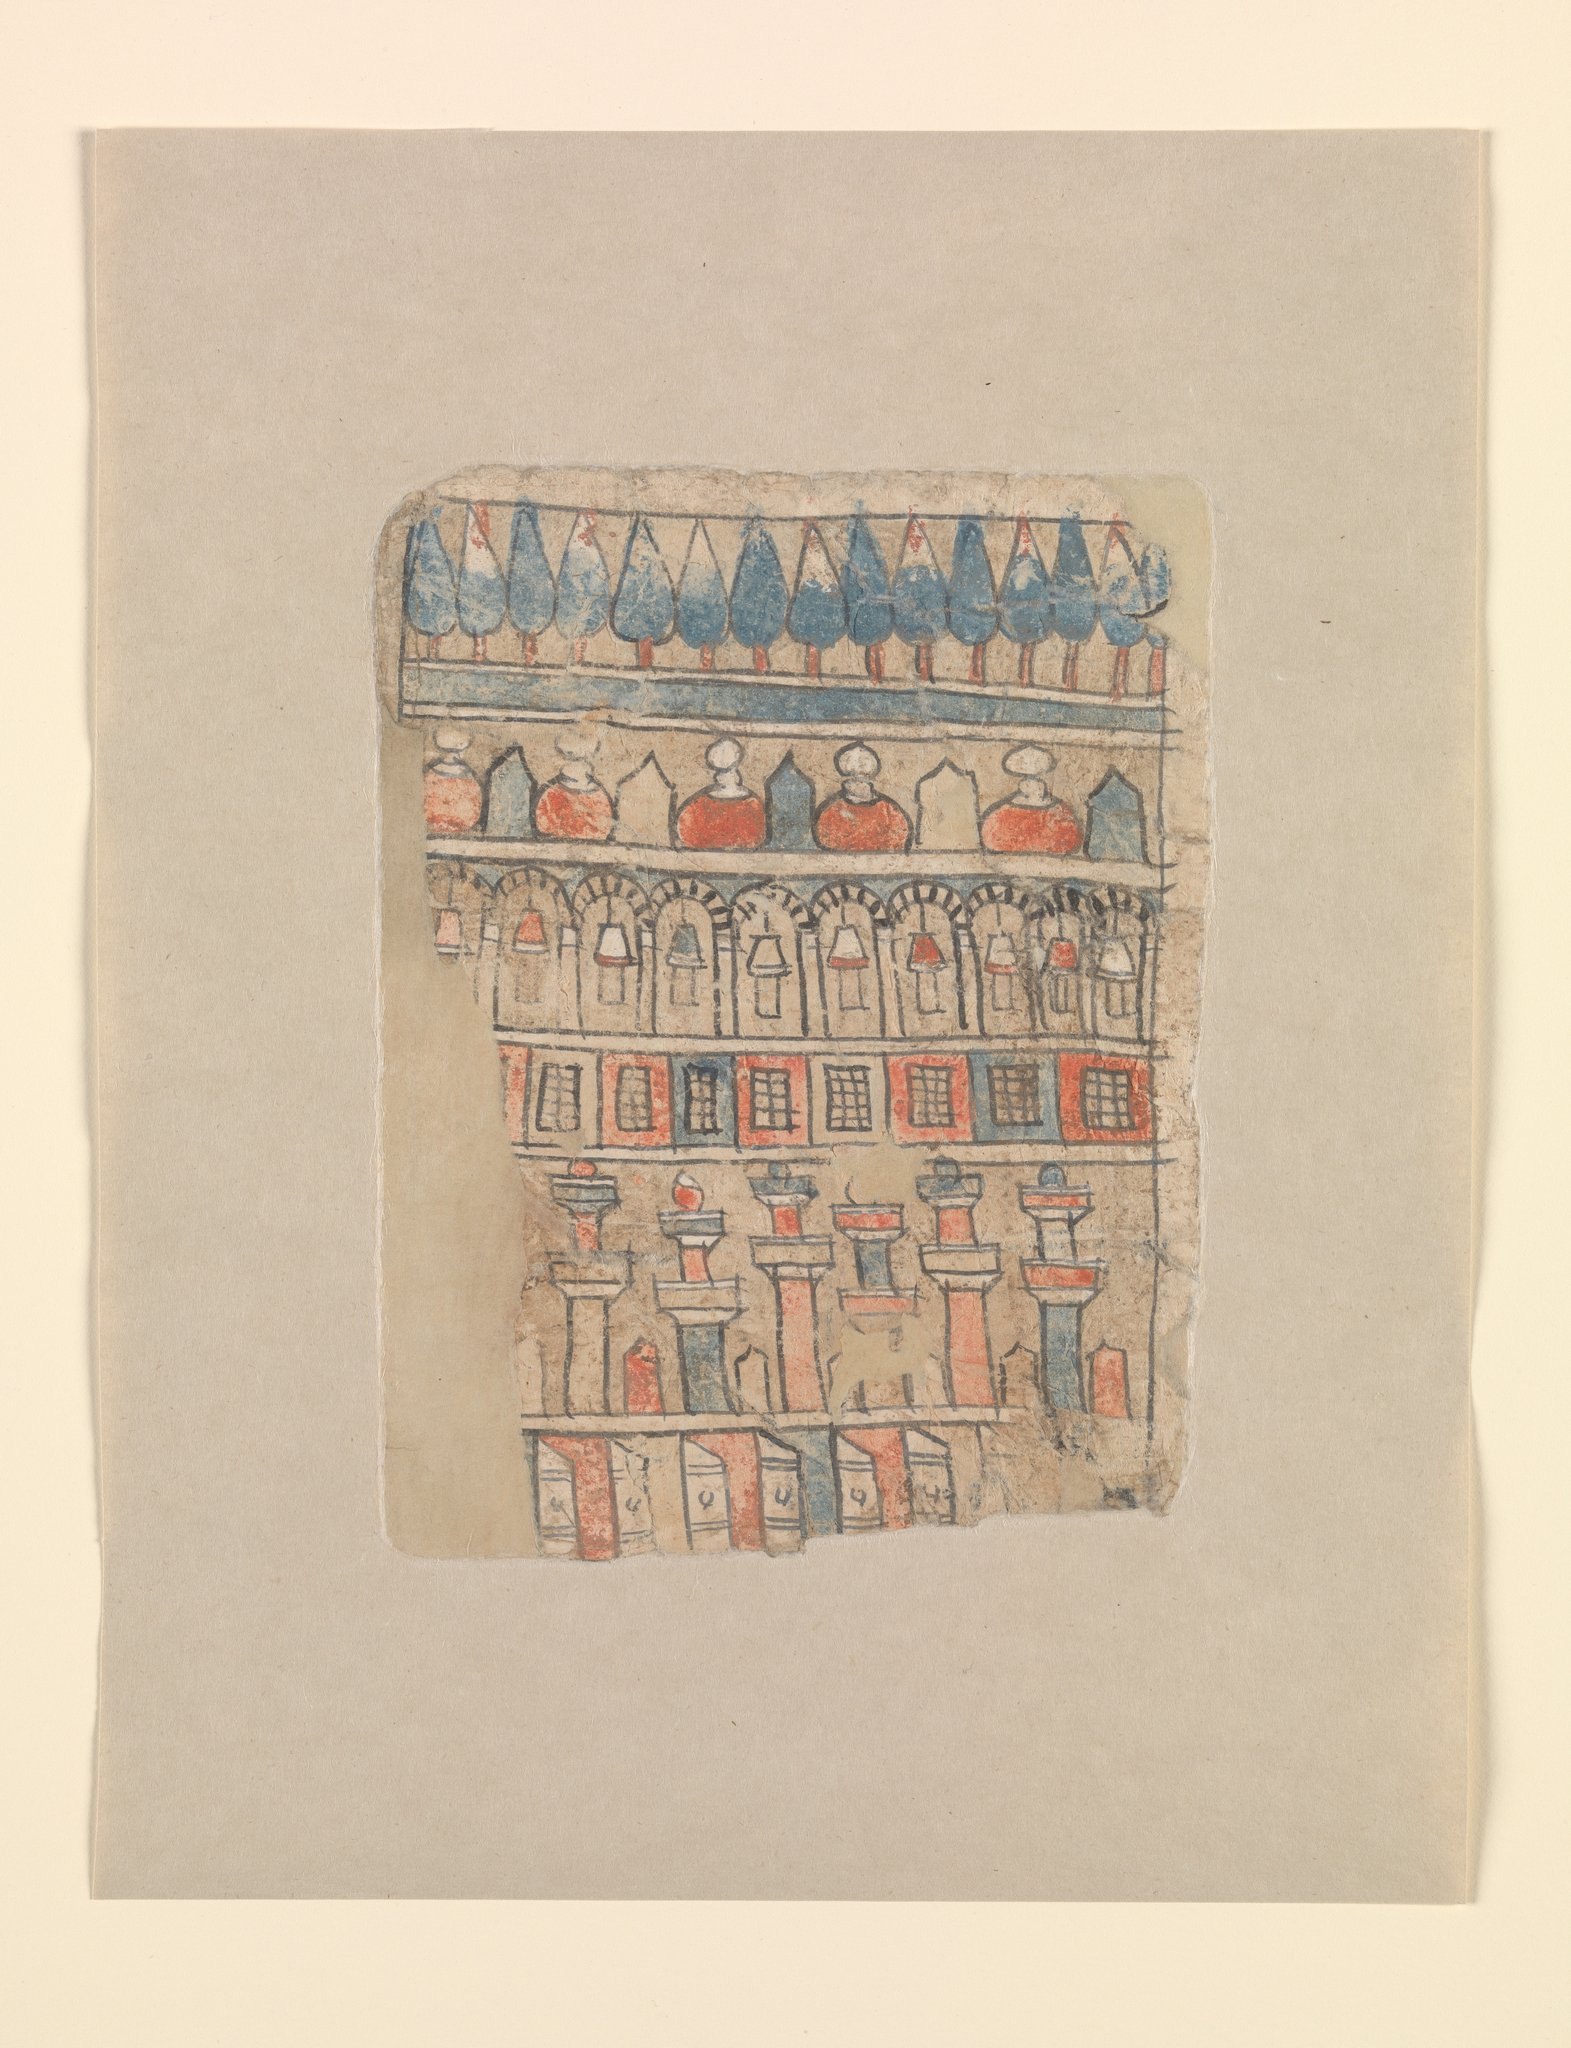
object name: folio from an illustrated manuscript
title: Architectural Scene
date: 1501-1600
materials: ink, paper, watercolor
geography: turkey